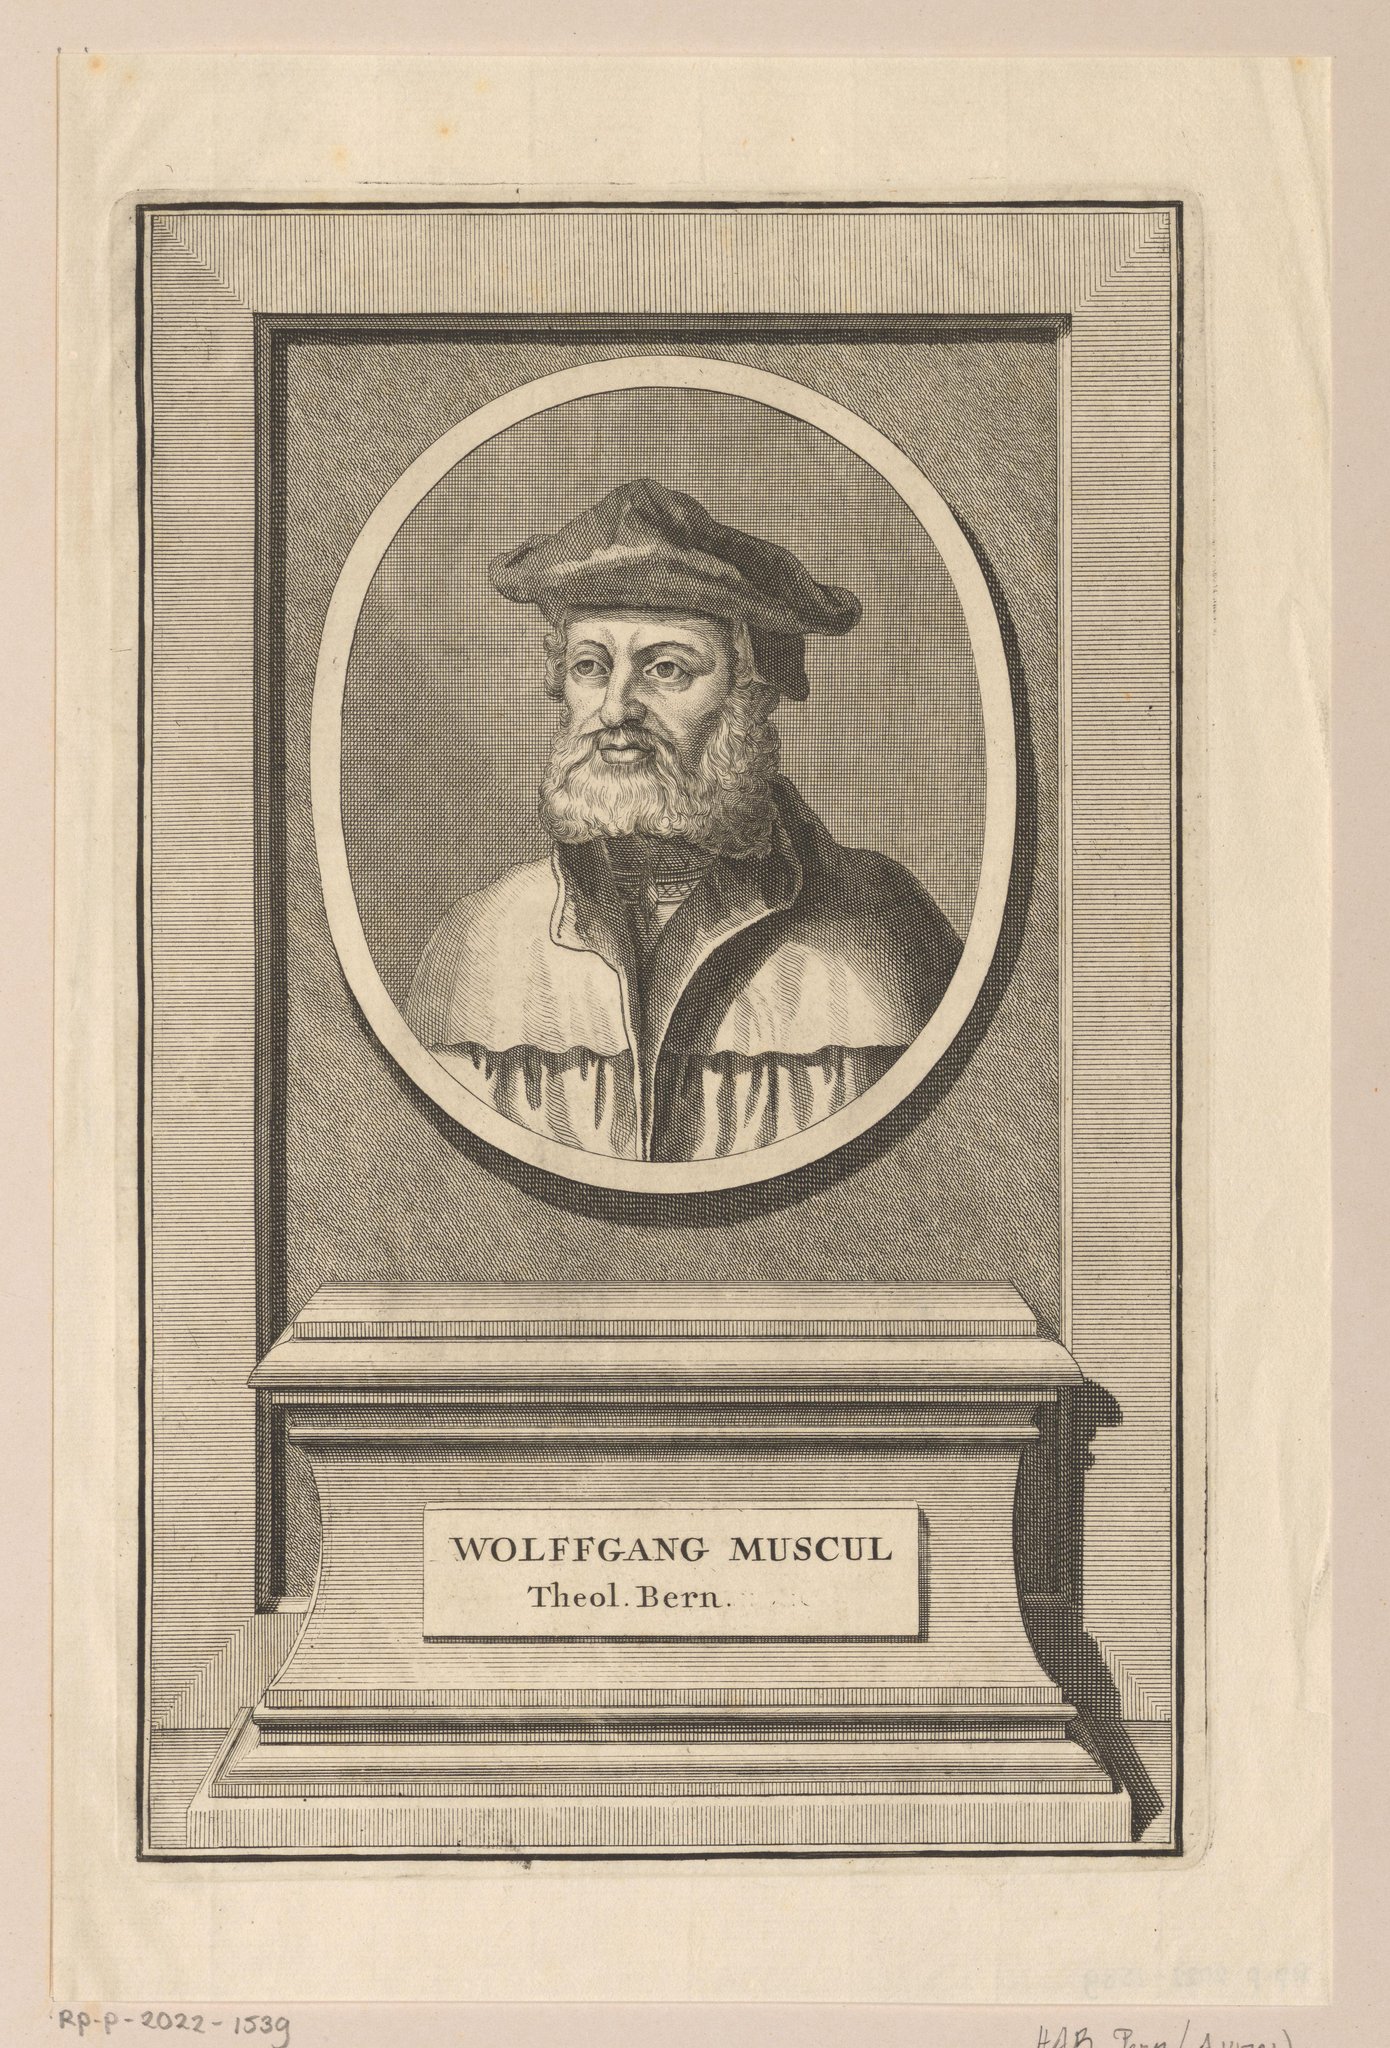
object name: print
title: Wolffgang Muscul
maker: Anonymous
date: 1600-1750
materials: paper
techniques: engraving, etching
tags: theologian, historical persons